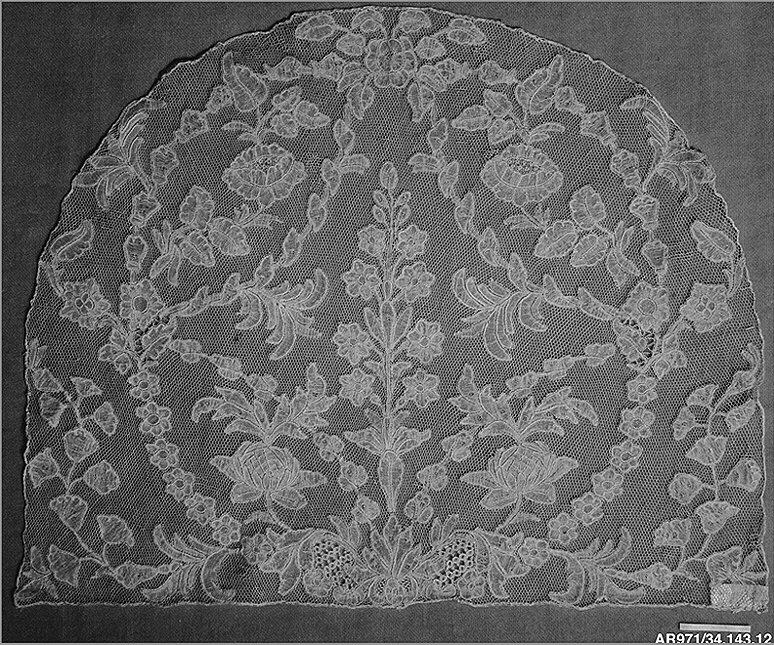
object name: cap crown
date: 1701-1800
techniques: lace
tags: flowers